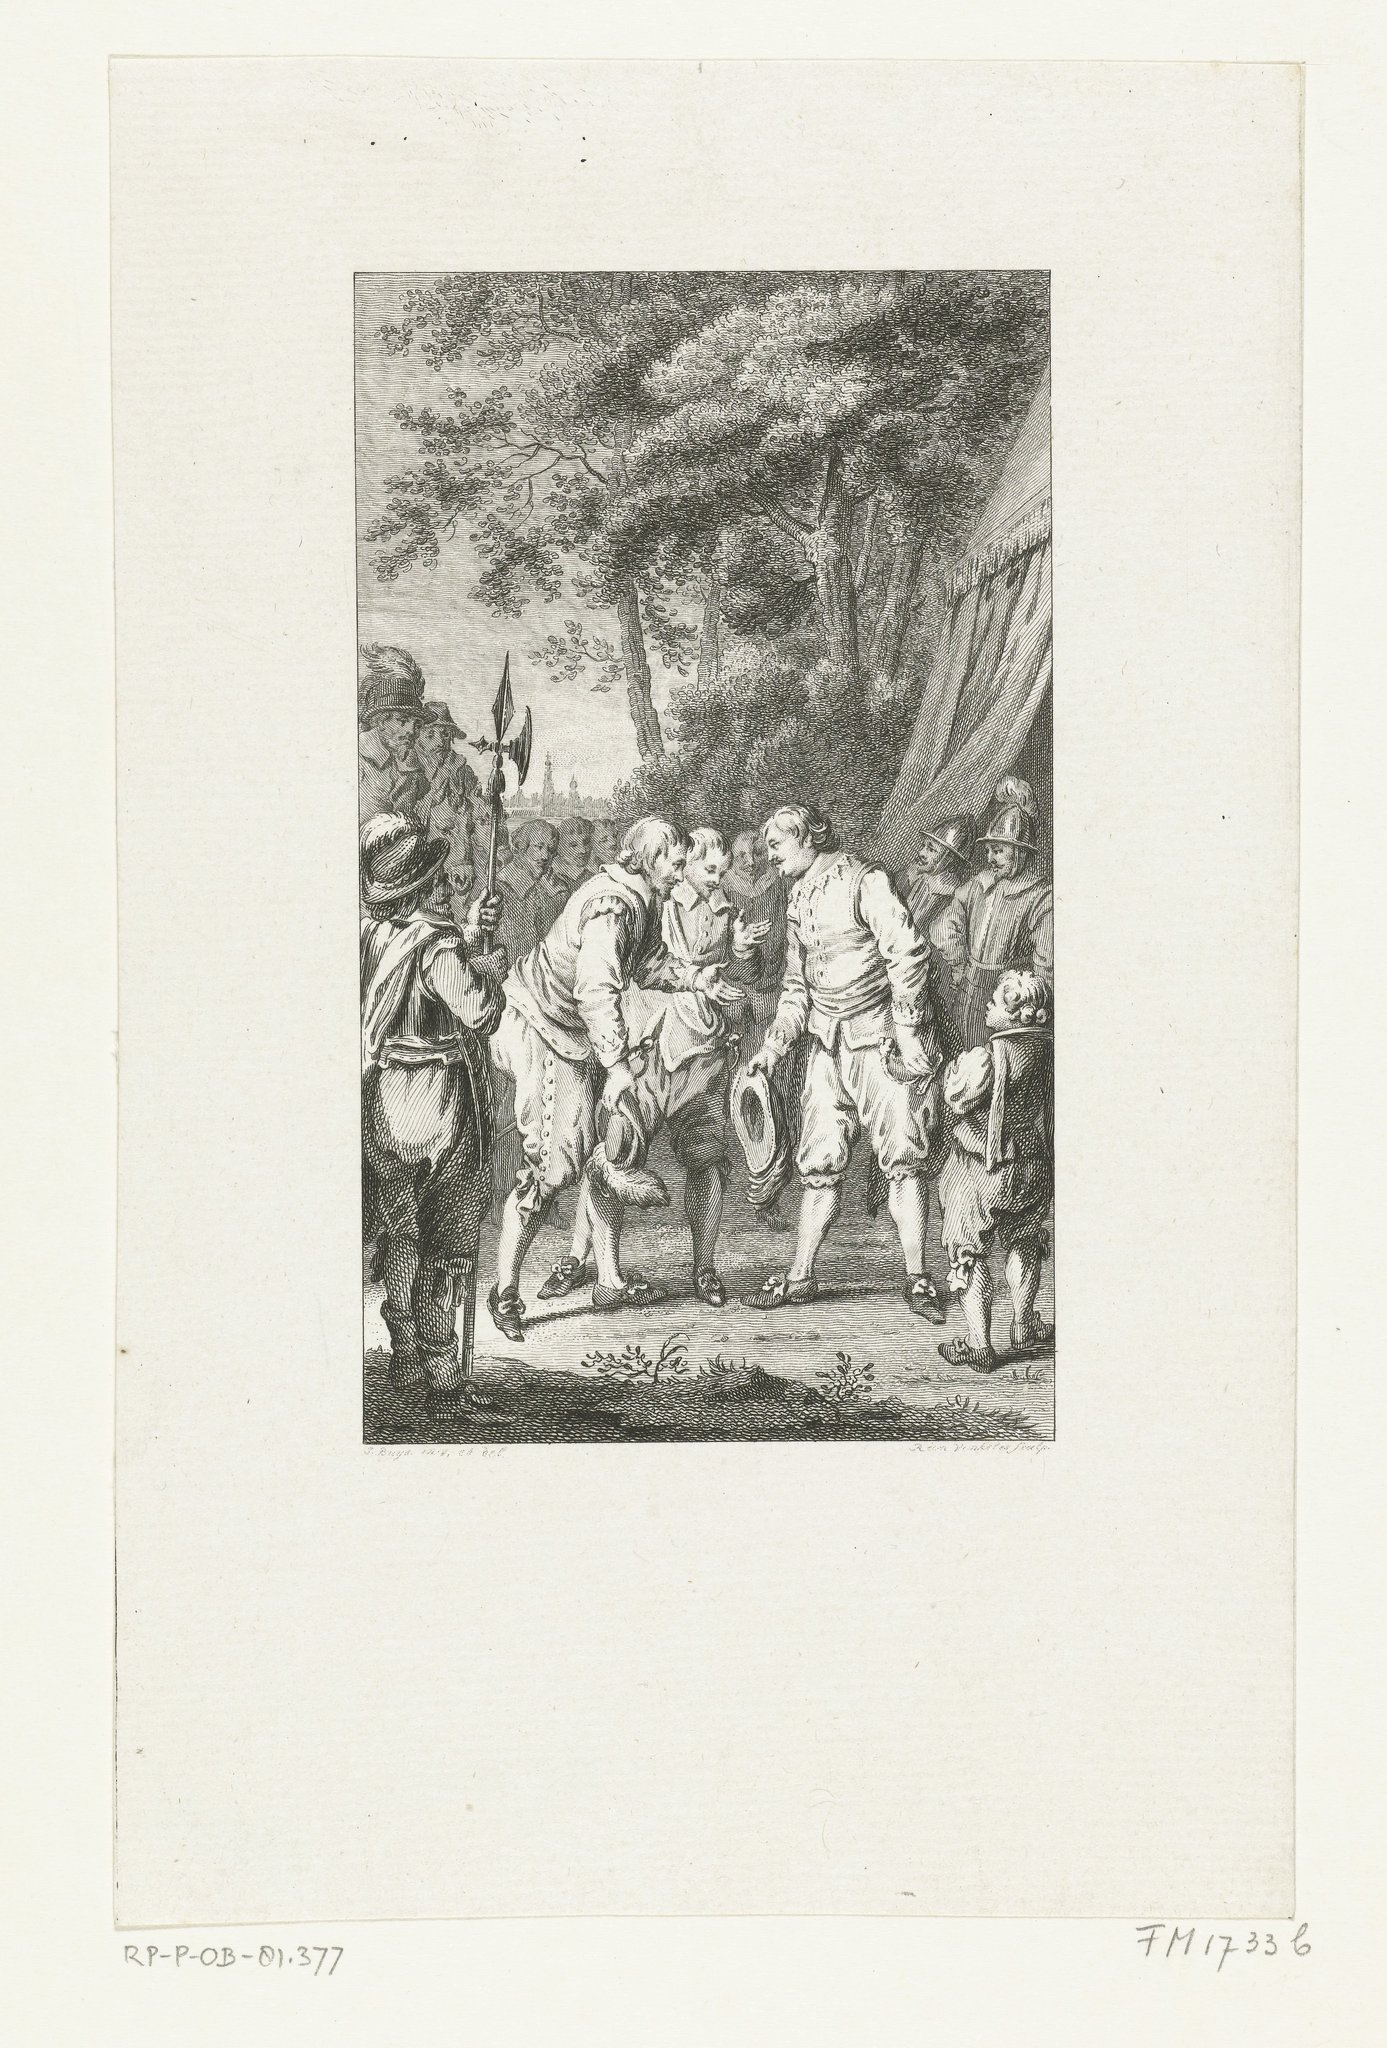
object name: print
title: Frederik Hendrik wordt als veldheer in het Franse leger begroet, 1635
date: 1786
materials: paper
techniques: etching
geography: northern netherlands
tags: delft, the hague, frederick henry (prince of orange), siege, position war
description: Gebruikt als illustratie in: Jacobus Kok, Vaderlandsch Woordenboek, Johannes Allart, Amsterdam 1785-1799, 35 delen, dl. XVI, pl. II. Staat vóór de letter.